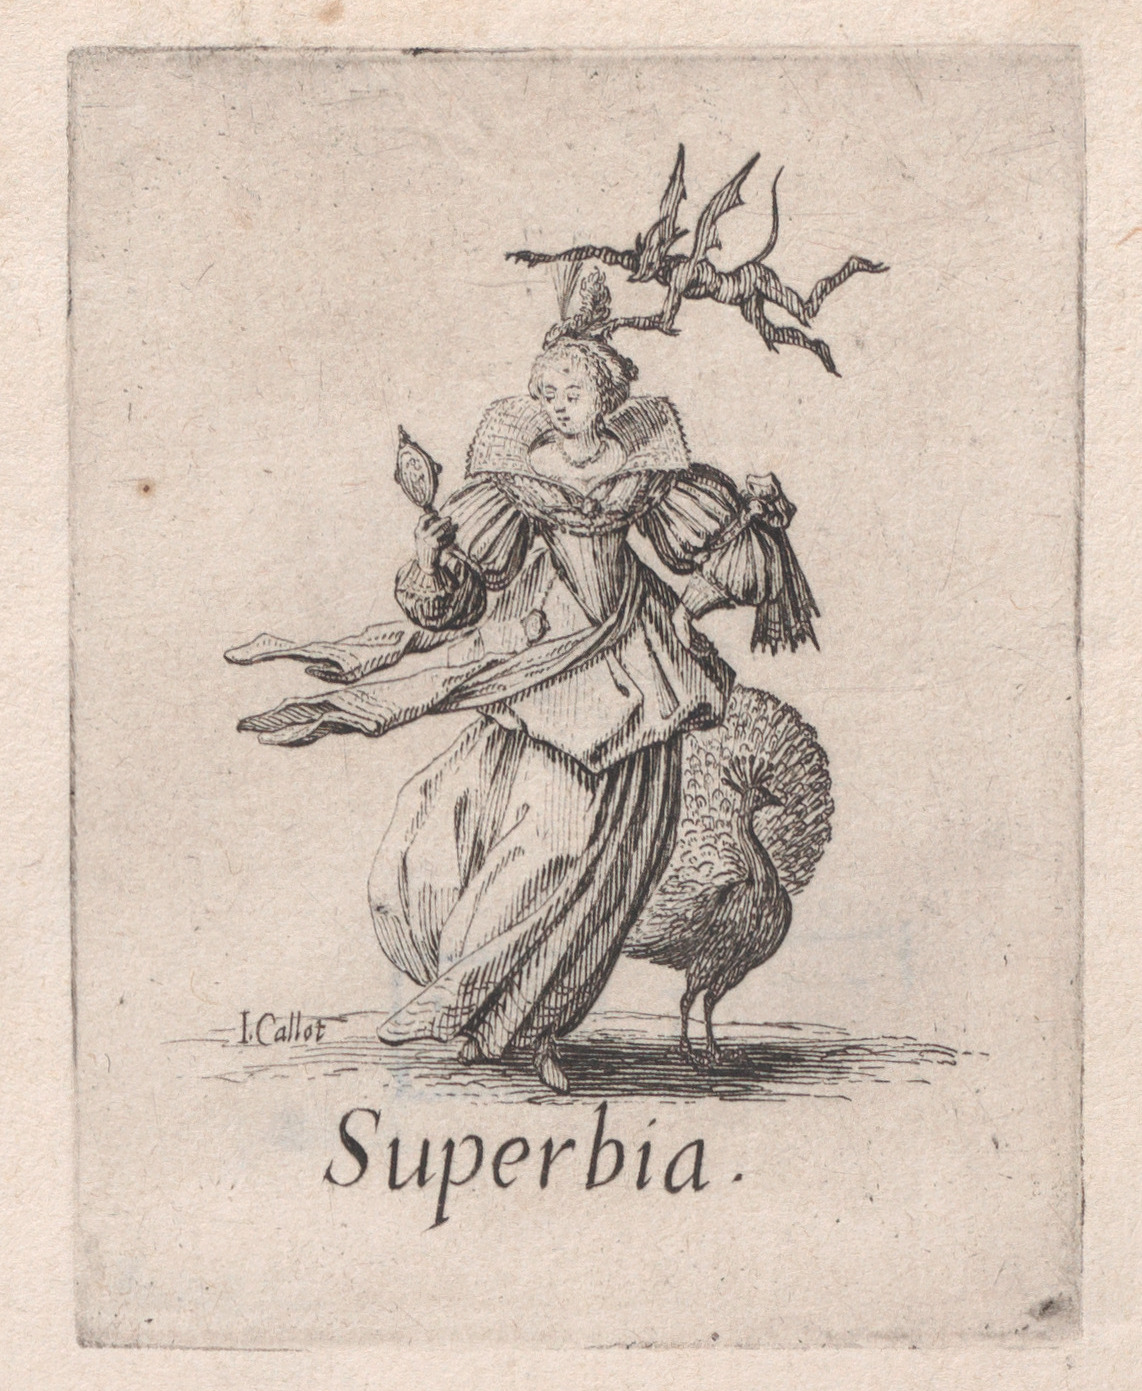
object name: print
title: L'Orgueil (Pride), from "Les Péchées Capitaux" (The Deadly Sins)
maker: jacques callot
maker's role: artist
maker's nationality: french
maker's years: 1592-1635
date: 1620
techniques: engraving, etching